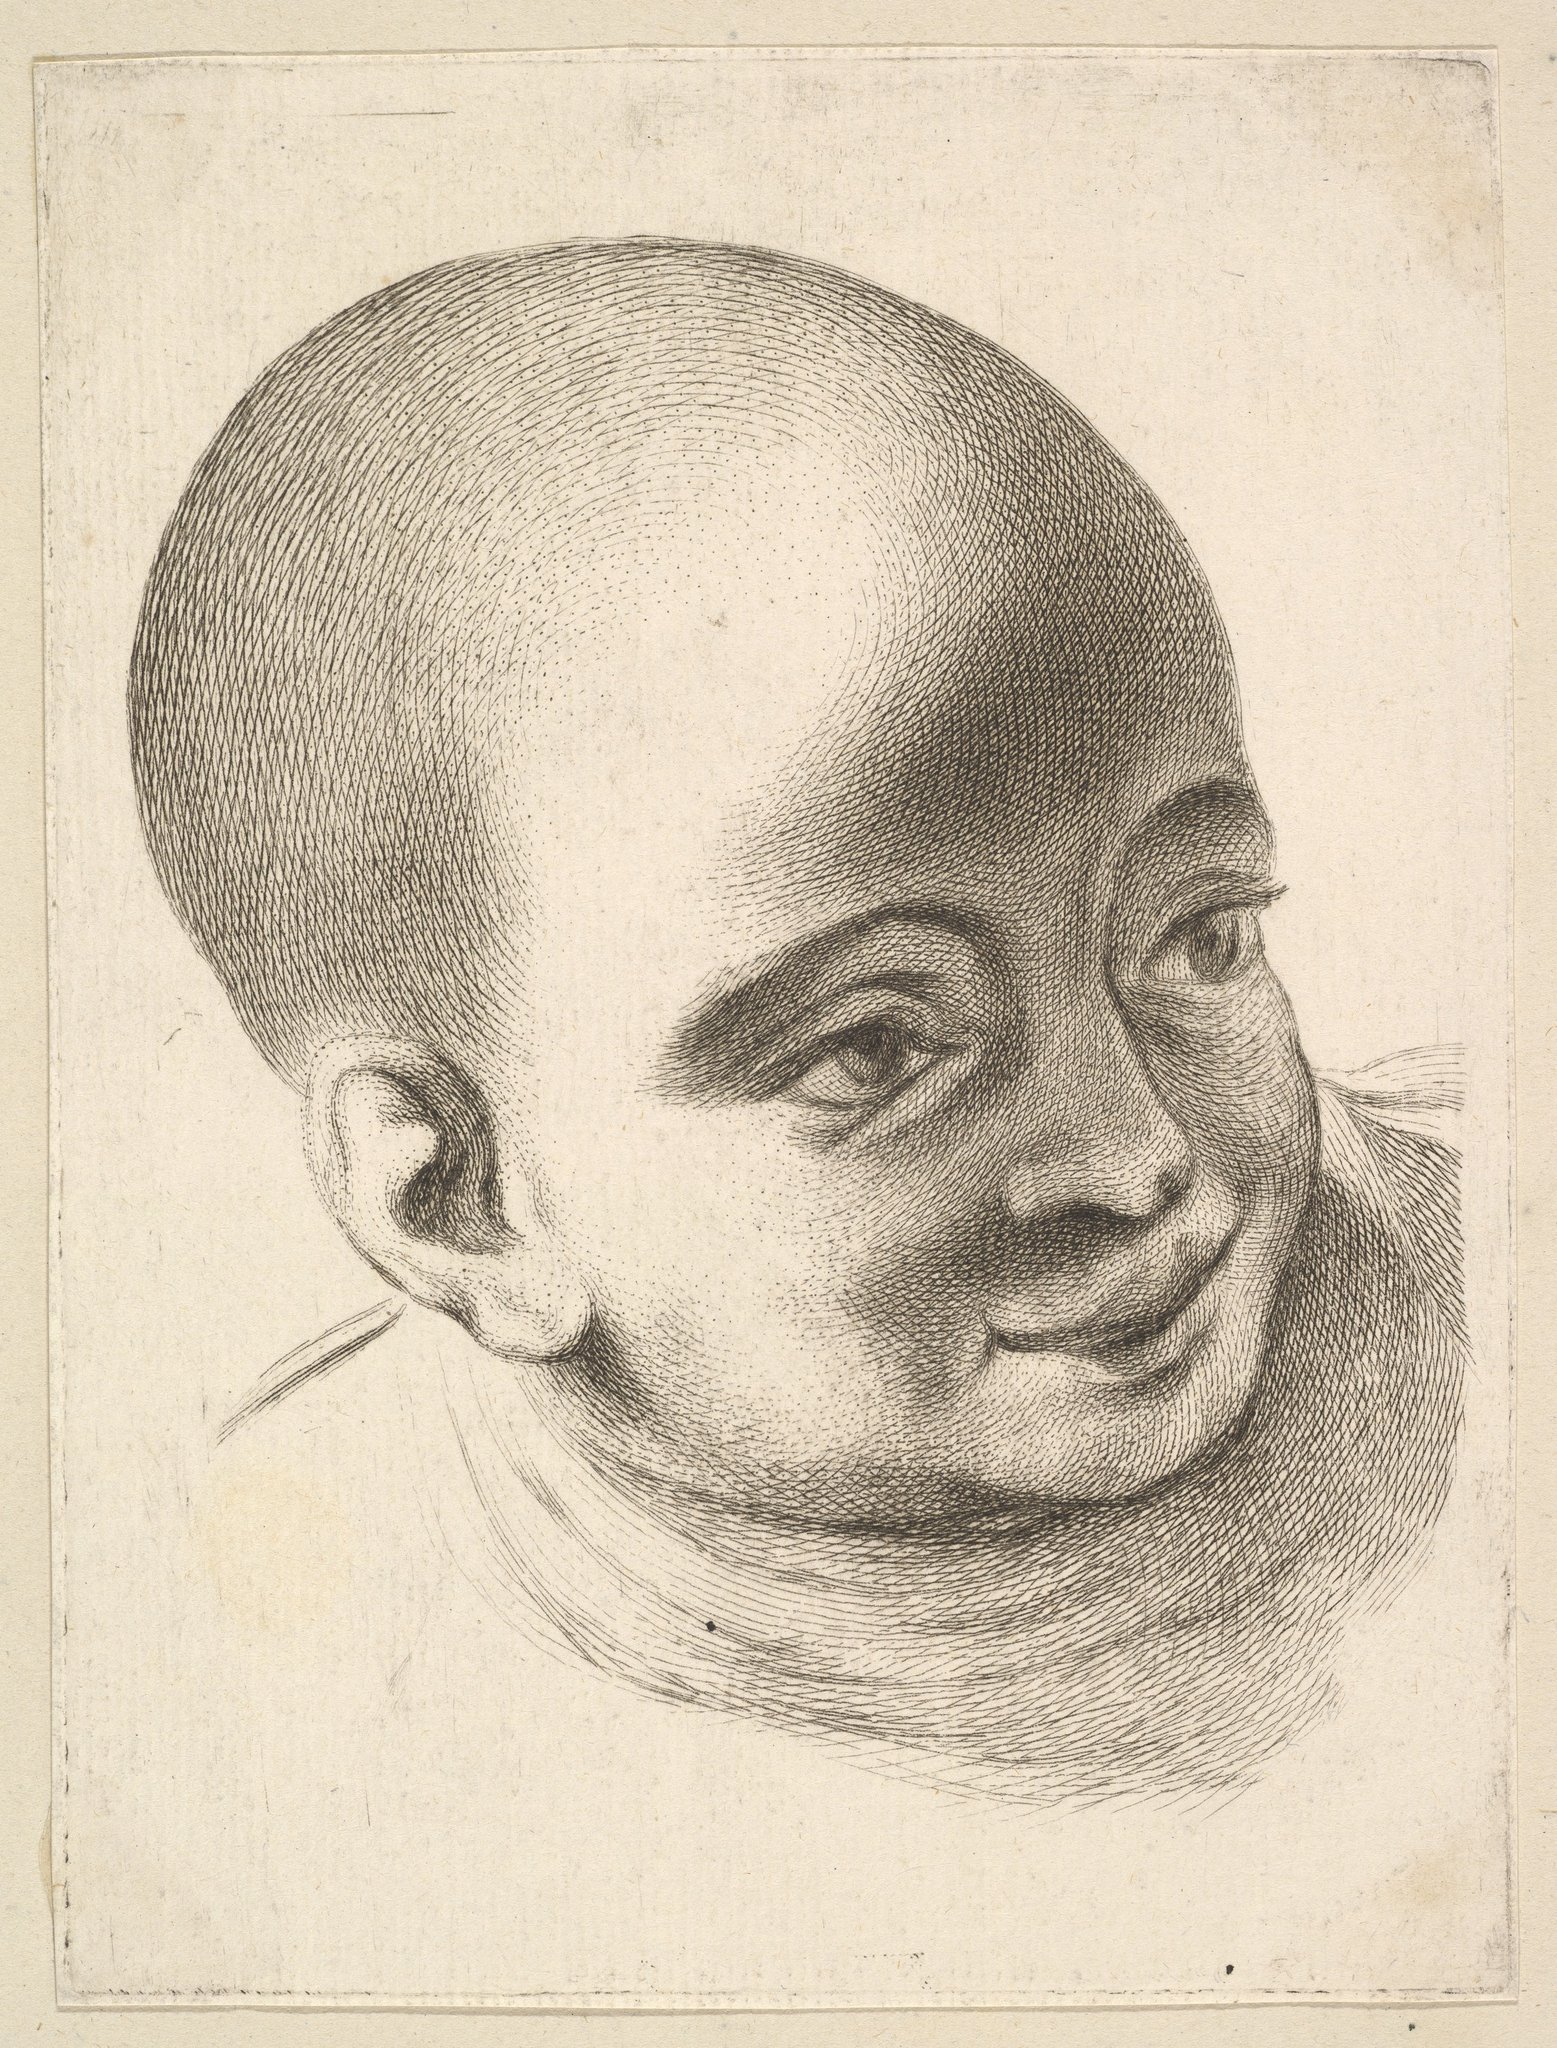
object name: print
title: Head of a Child, from Livre de Têtes Gravées d'apres F. Boucher et Autres (Book of Heads Engraved after F. Boucher and Others)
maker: anonymous, french, 18th century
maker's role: artist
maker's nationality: french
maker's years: 1700-1800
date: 1701-1800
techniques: engraving, etching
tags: heads,children